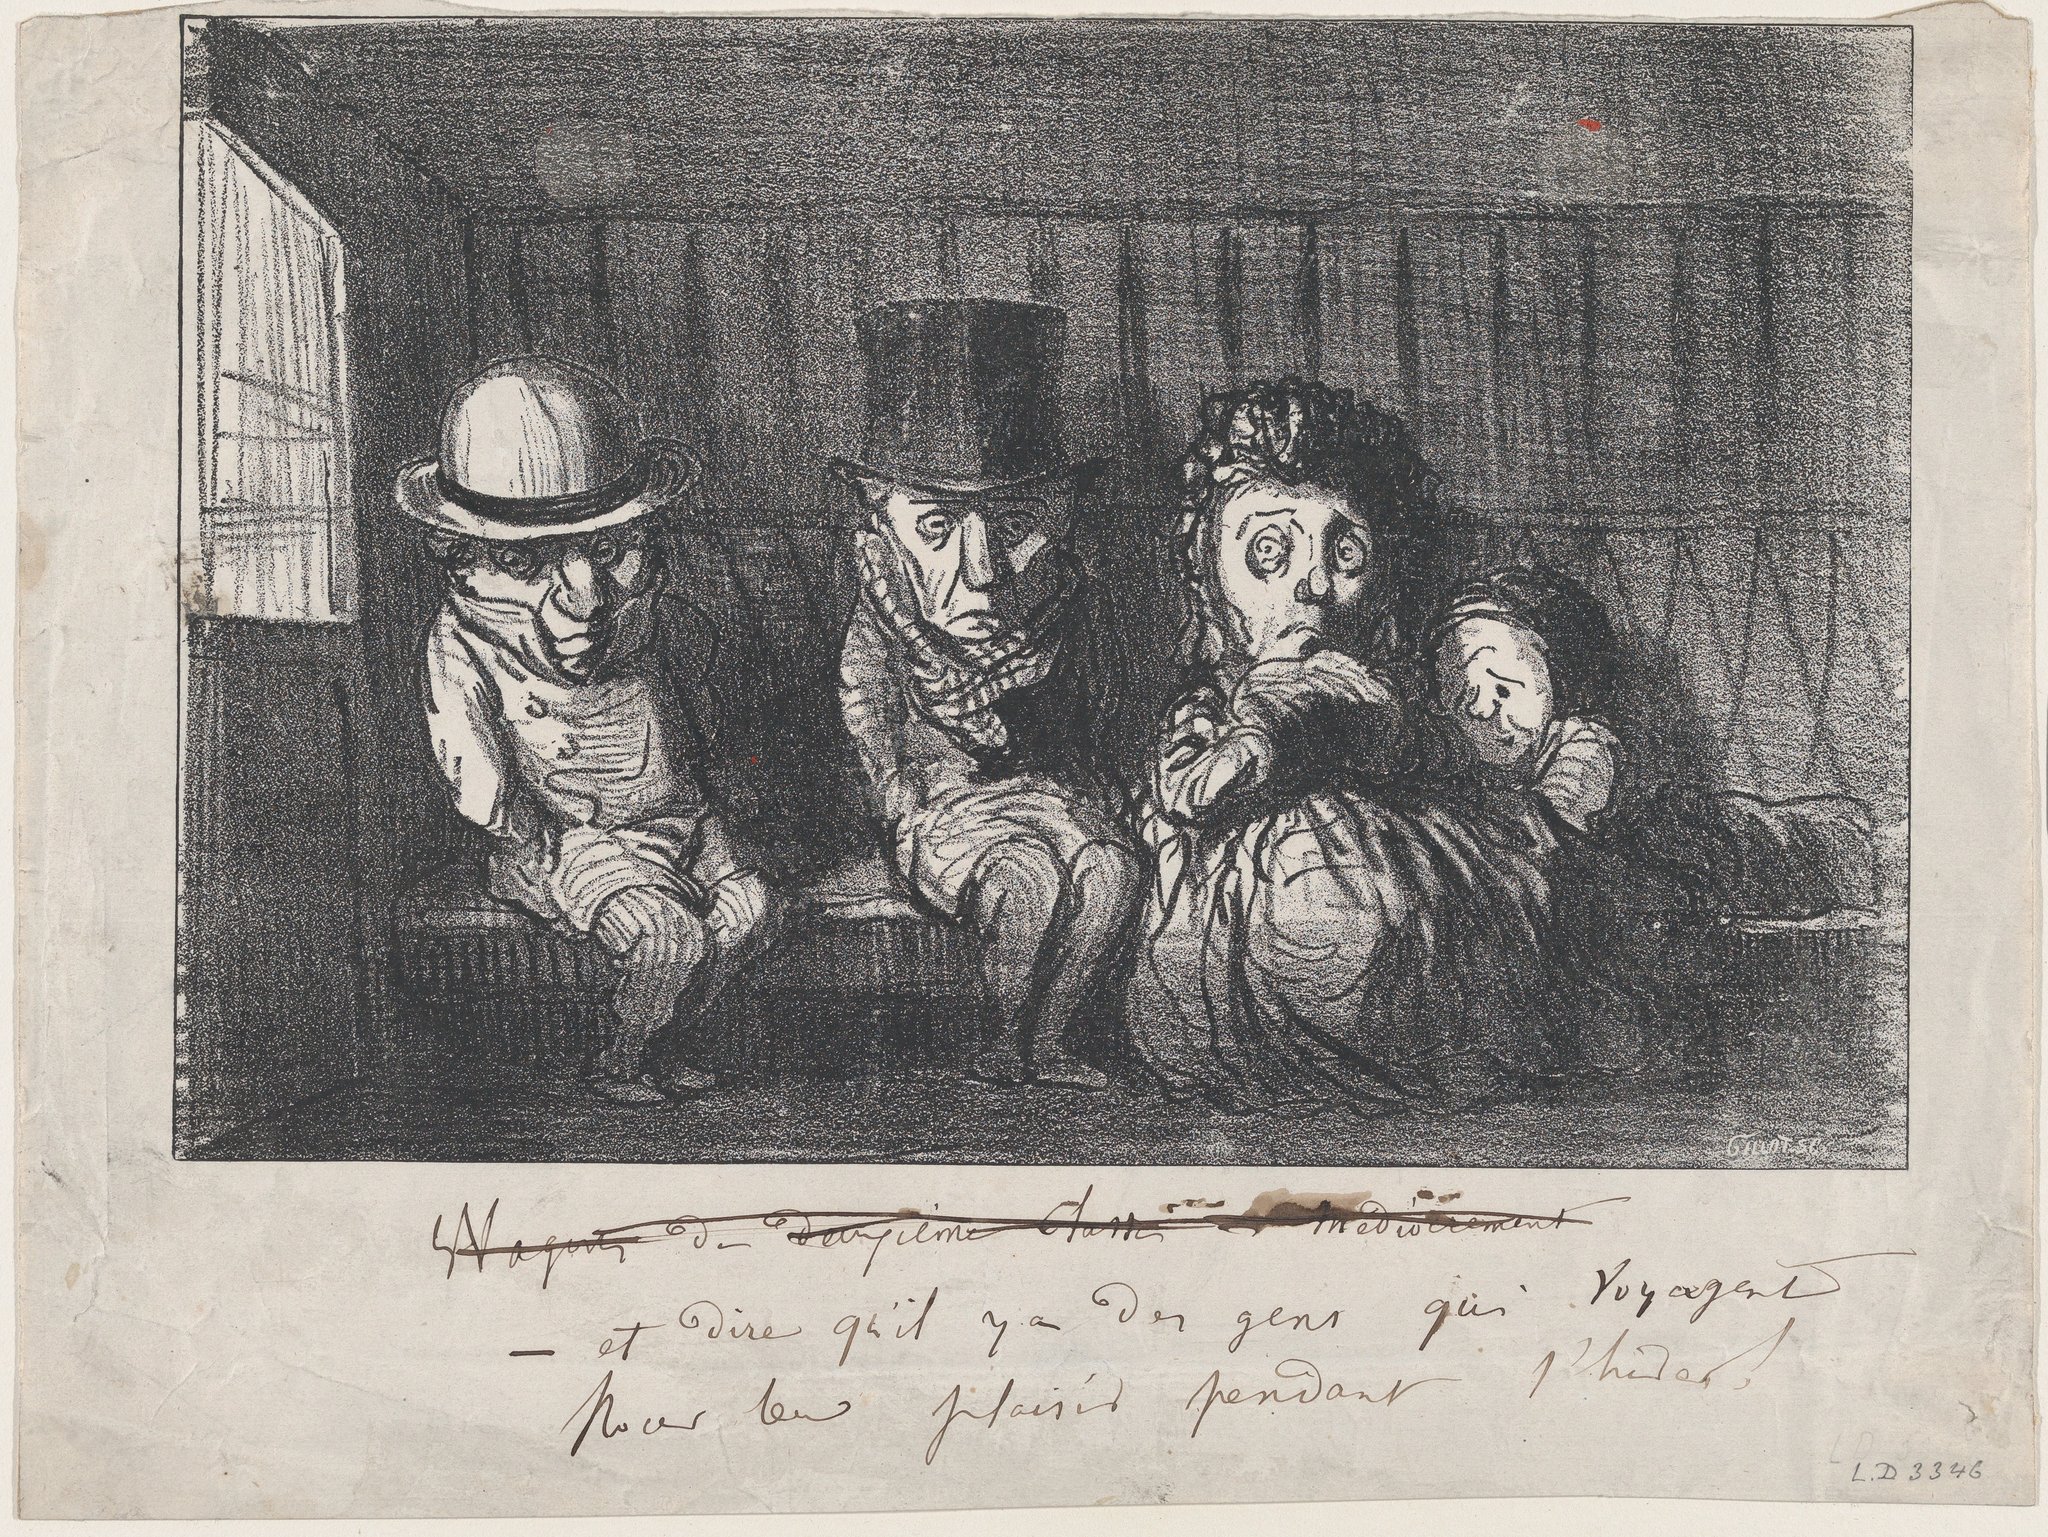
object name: print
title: To imagine that there are people who even travel in winter for fun and enjoyment!, from "Winter Sketches"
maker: honoré daumier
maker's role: artist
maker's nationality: french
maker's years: 1808-1879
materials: ink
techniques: lithograph, pen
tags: satire,children,men,women